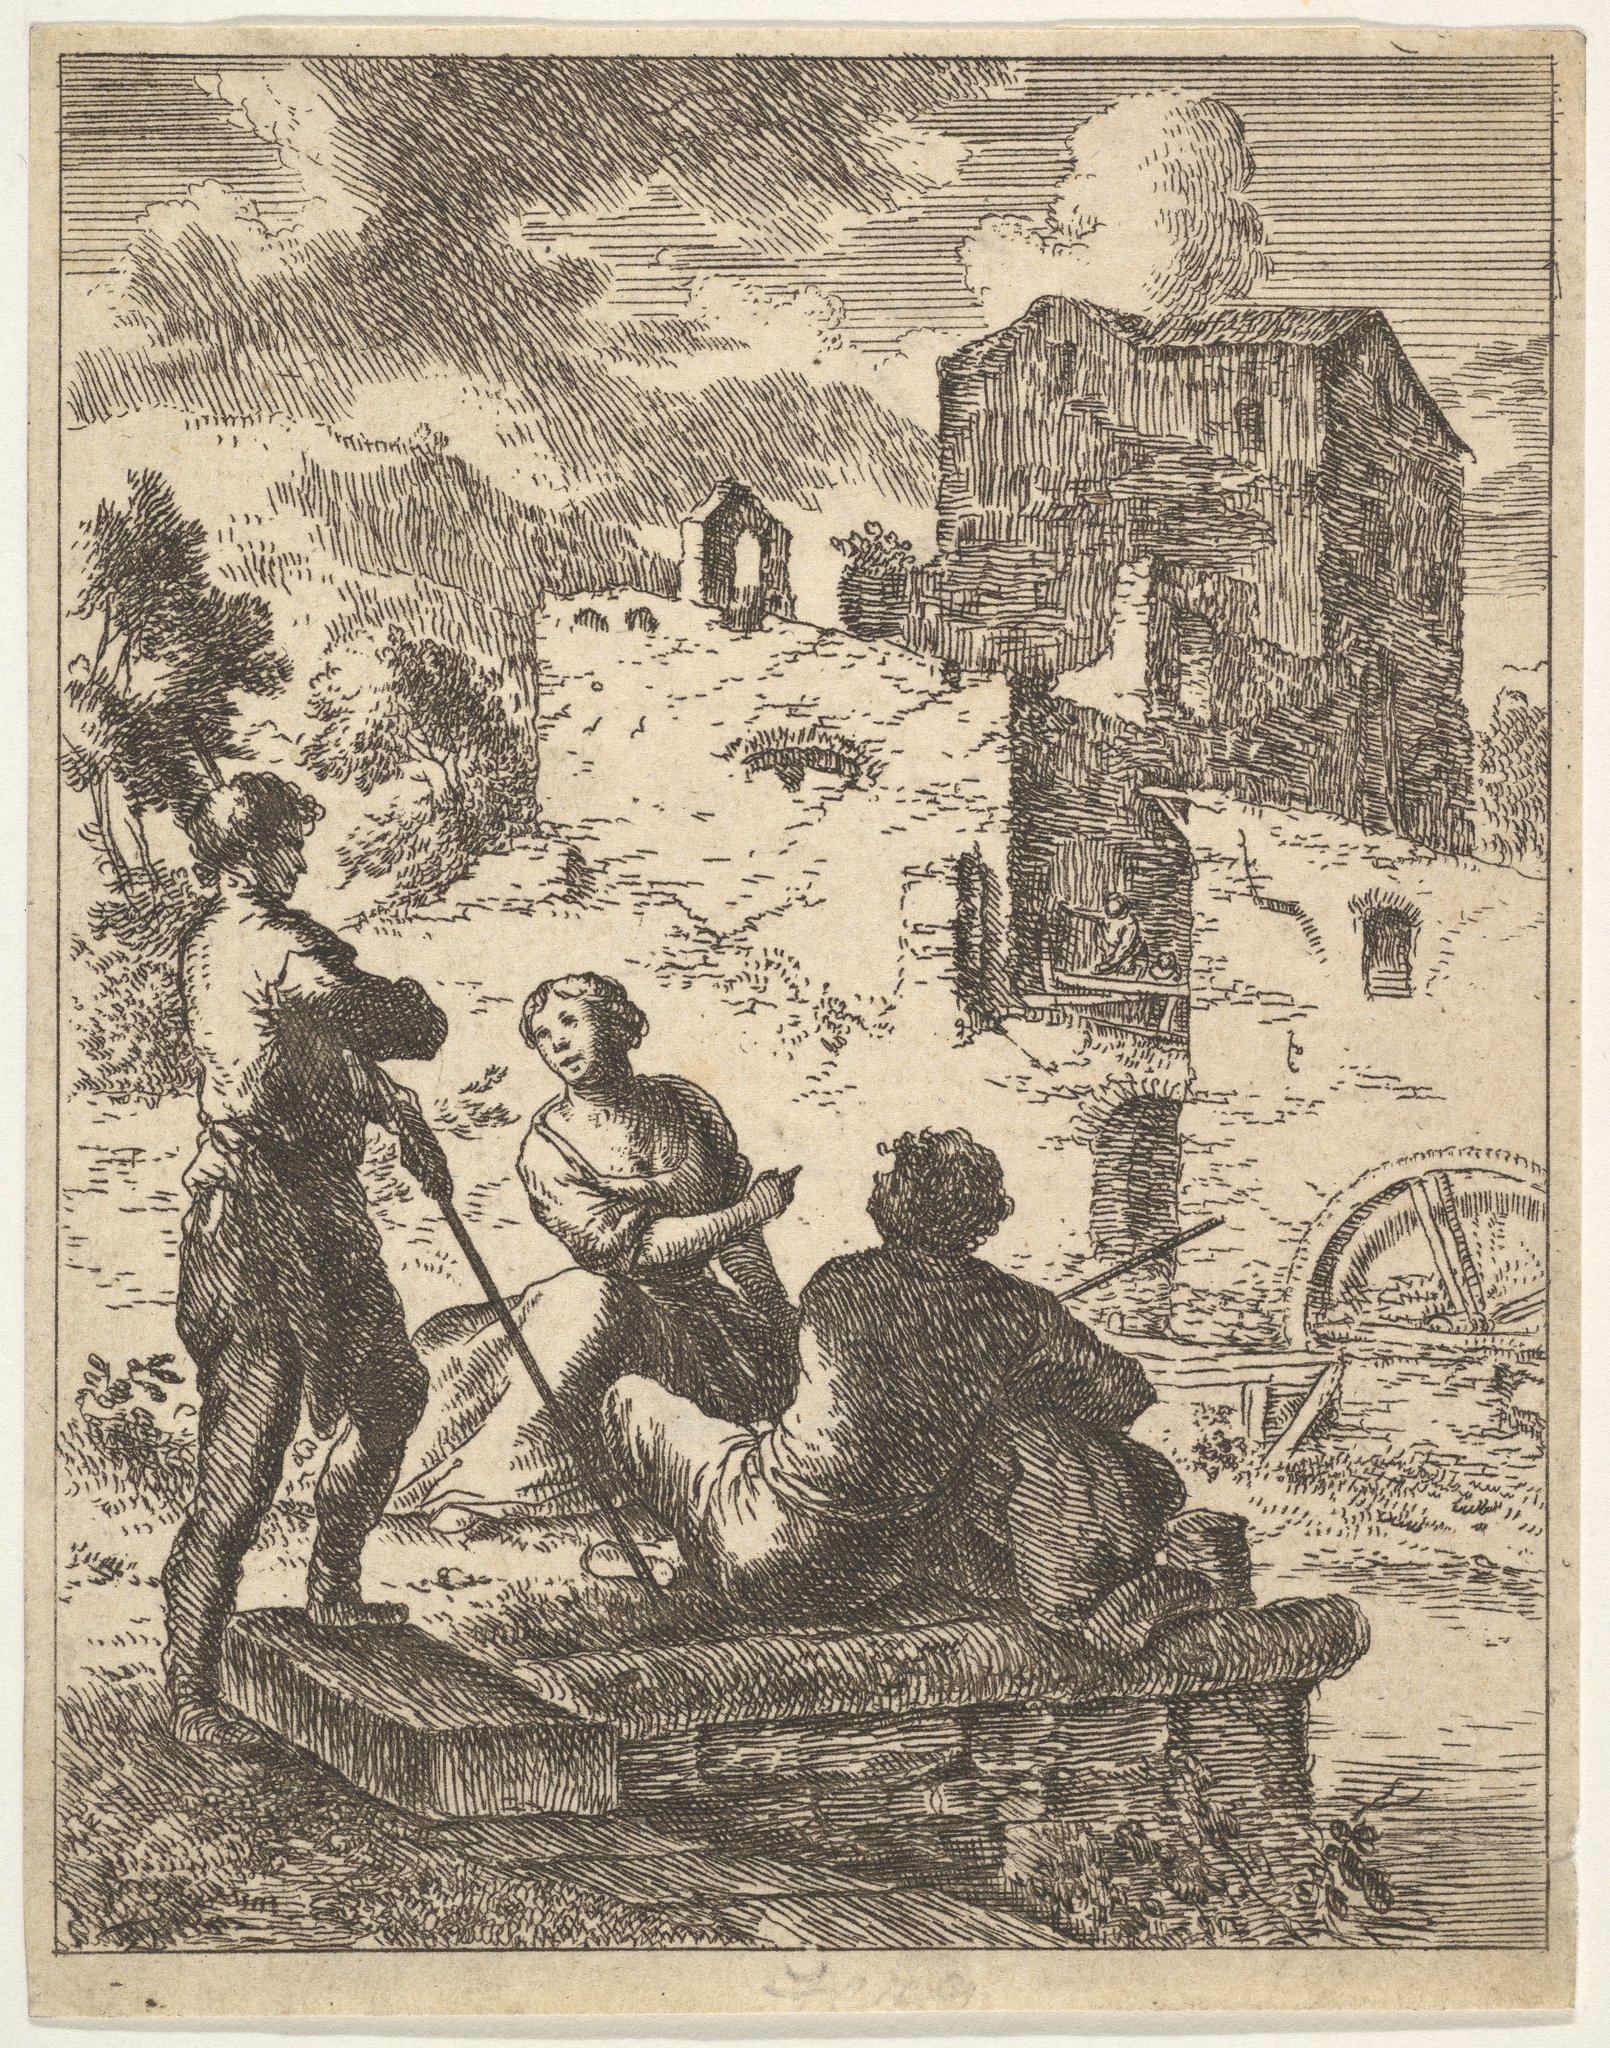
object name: print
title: Peasants and a Mill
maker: franz de paula ferg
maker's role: draughtsman, painter, print maker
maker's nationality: austrian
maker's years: 1689-1740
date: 1701-1800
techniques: etching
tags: factories,men,women